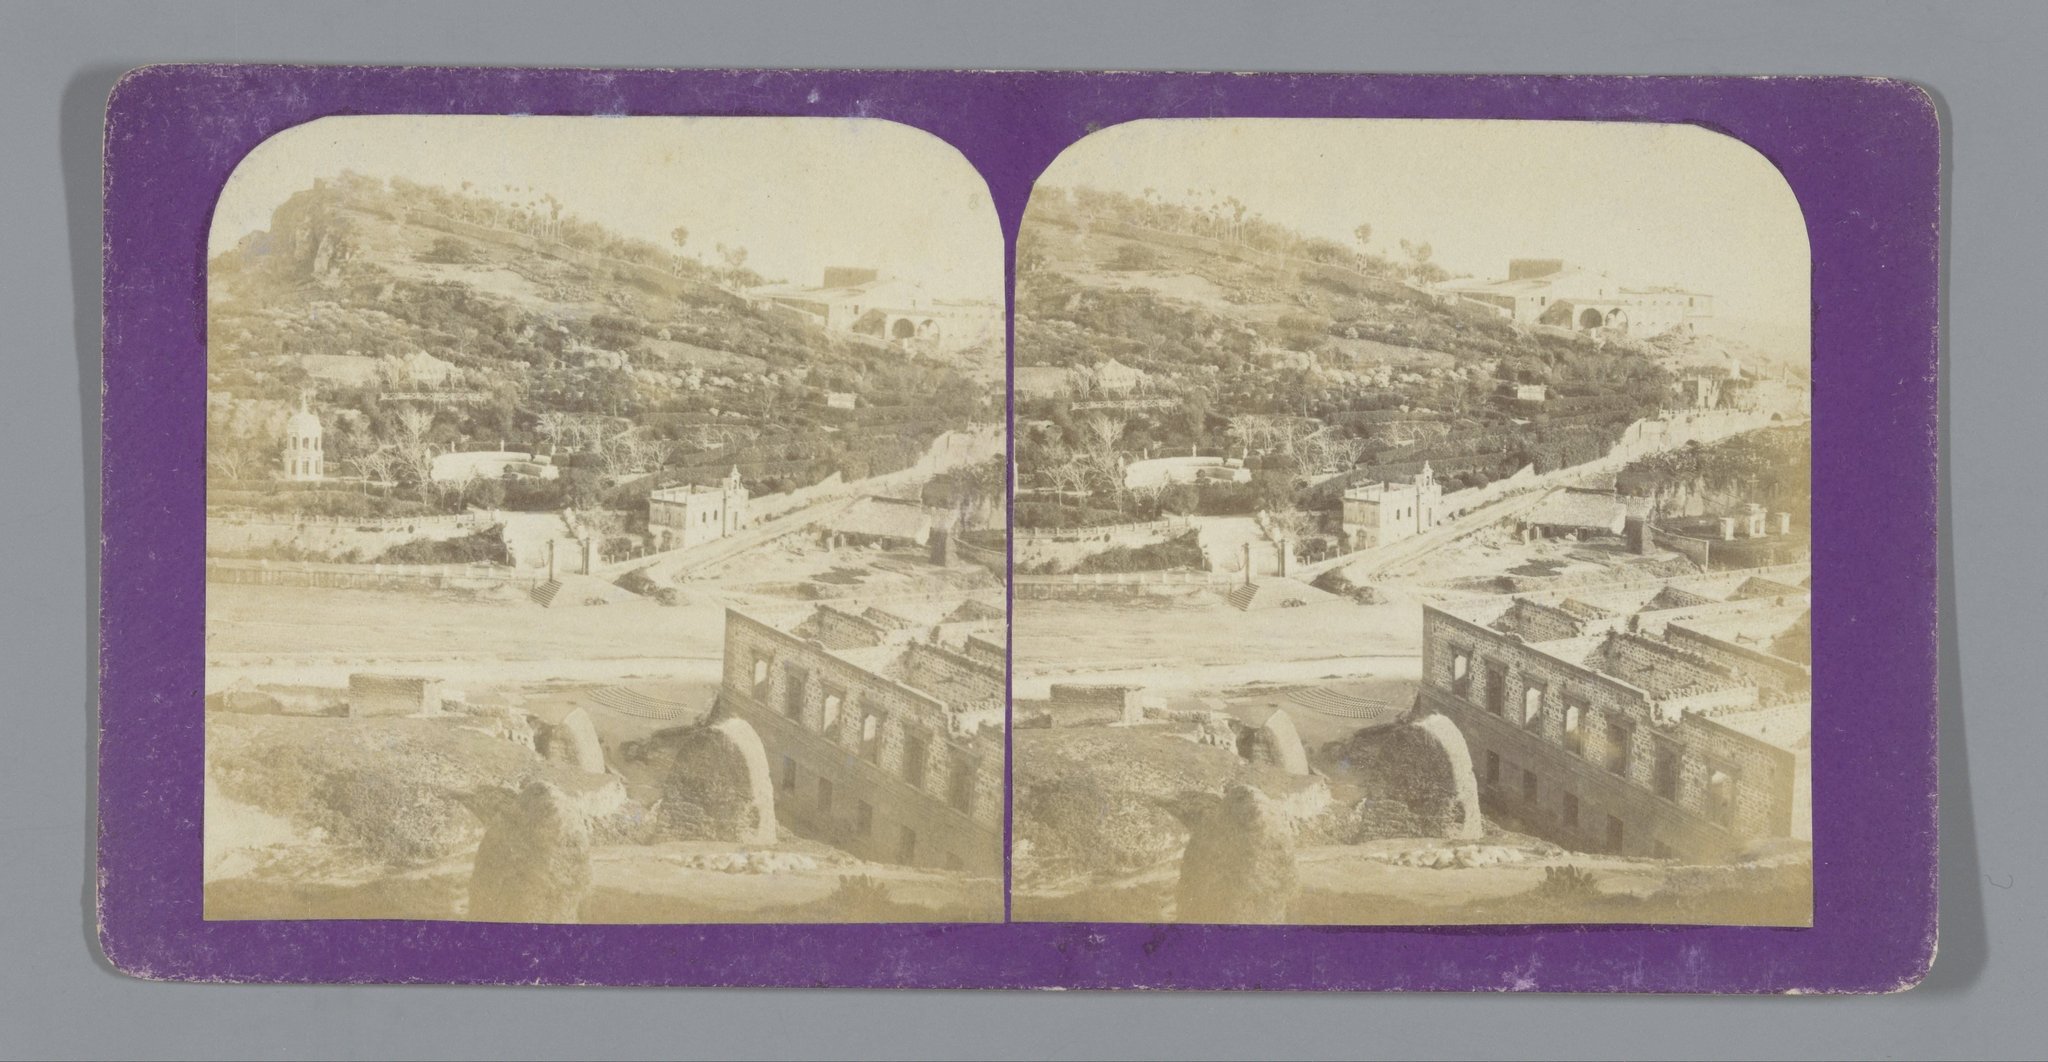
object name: stereograph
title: Gezicht op de Santo Spirito abdij van Agrigento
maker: jean andrieu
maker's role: fotograaf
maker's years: 1816-1872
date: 1862-1876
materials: cardboard, paper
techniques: albumen print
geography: agrigento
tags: abbey, monastery, convent ~ roman catholic church, mountains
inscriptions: title: ‘1310 Montagne et couvent de Saint Vito (Girgenti)’